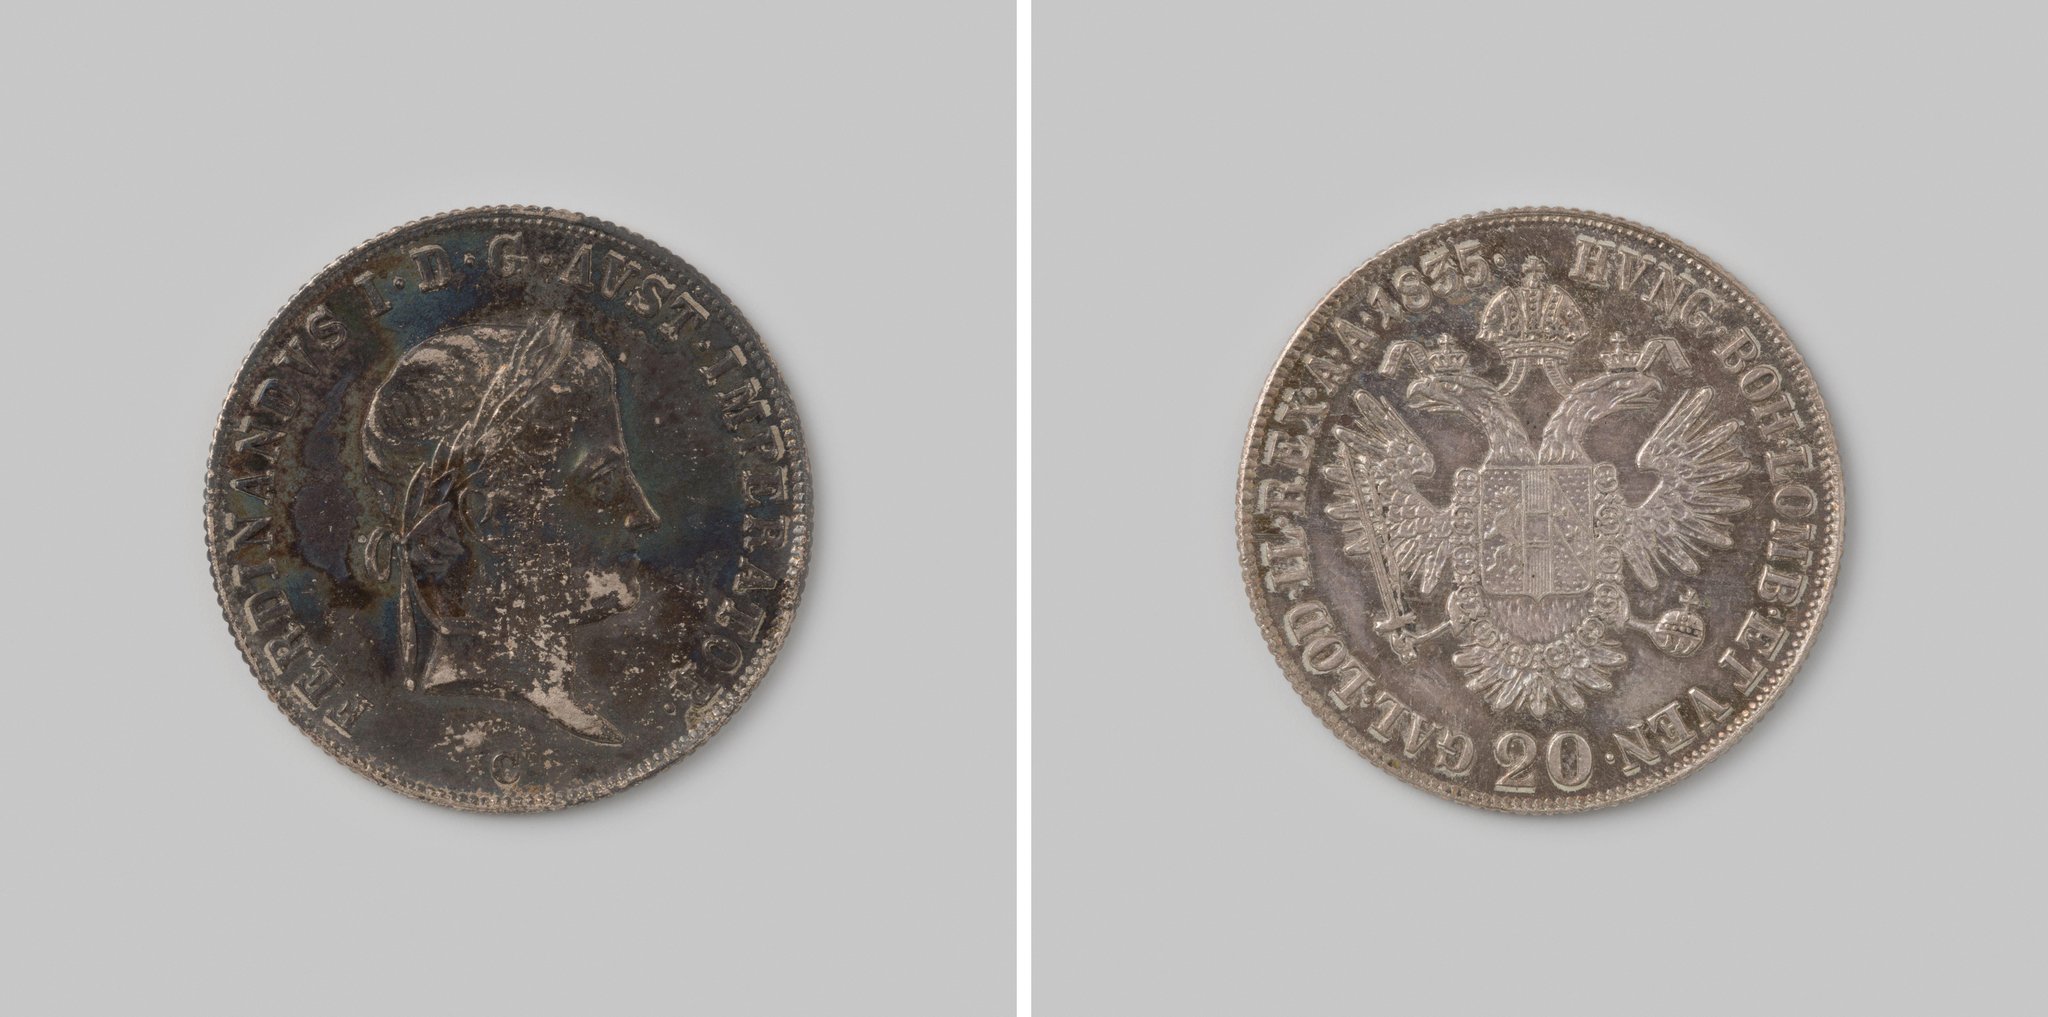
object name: coin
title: 20 kreuzer uit het keizerrijk Oostenrijk van Ferdinand, 1835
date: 1835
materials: silver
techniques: striking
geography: prague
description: Zilveren munt. Voorzijde: binnen twee samengebonden takken gelauwerd hoofd van de keizer naar rechts, waaronder letter C [=Praag]. Keerzijde: gekroonde dubbelkoppige adelaar met op de koppen kleine kronen. Op zijn borst door ridderorde omhangen samengesteld wapenschild en in zijn poten een zwaard en een rijksappel. Waarde-aanduiding onderaan, jaartal aan het eind van het omschrift. Kartelrand.